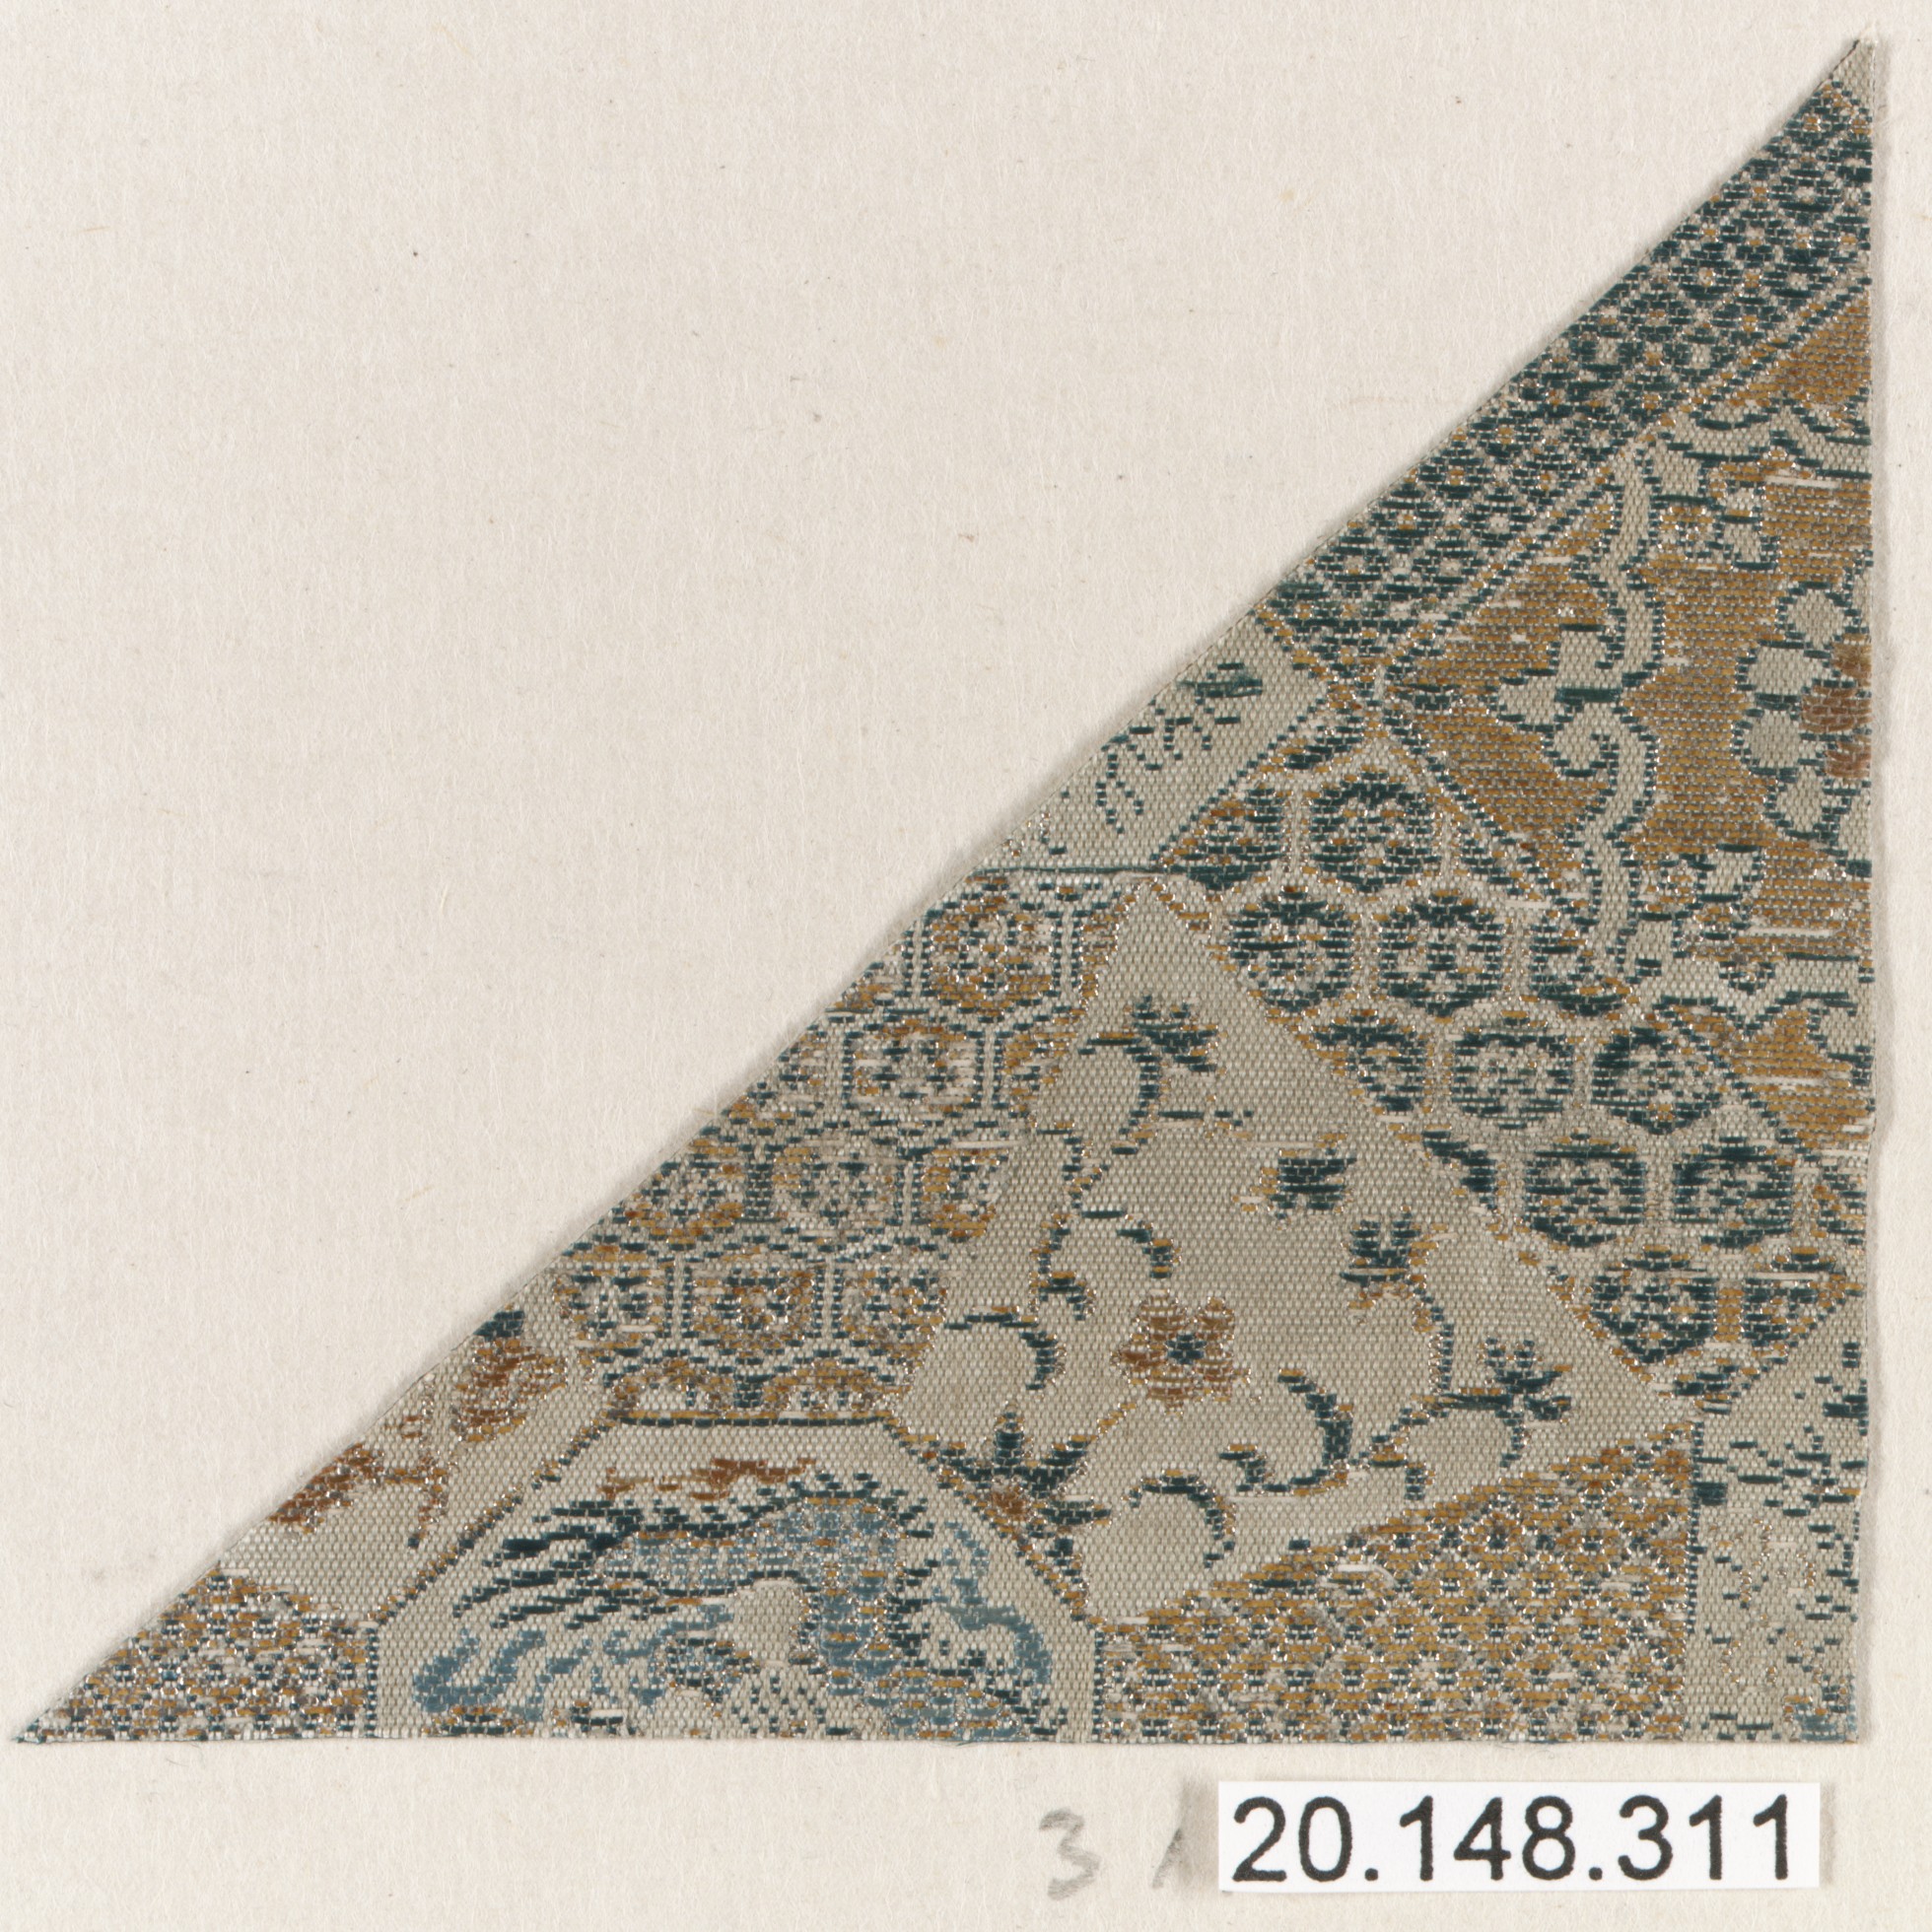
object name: piece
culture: japanese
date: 1601-1700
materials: silk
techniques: compound weave